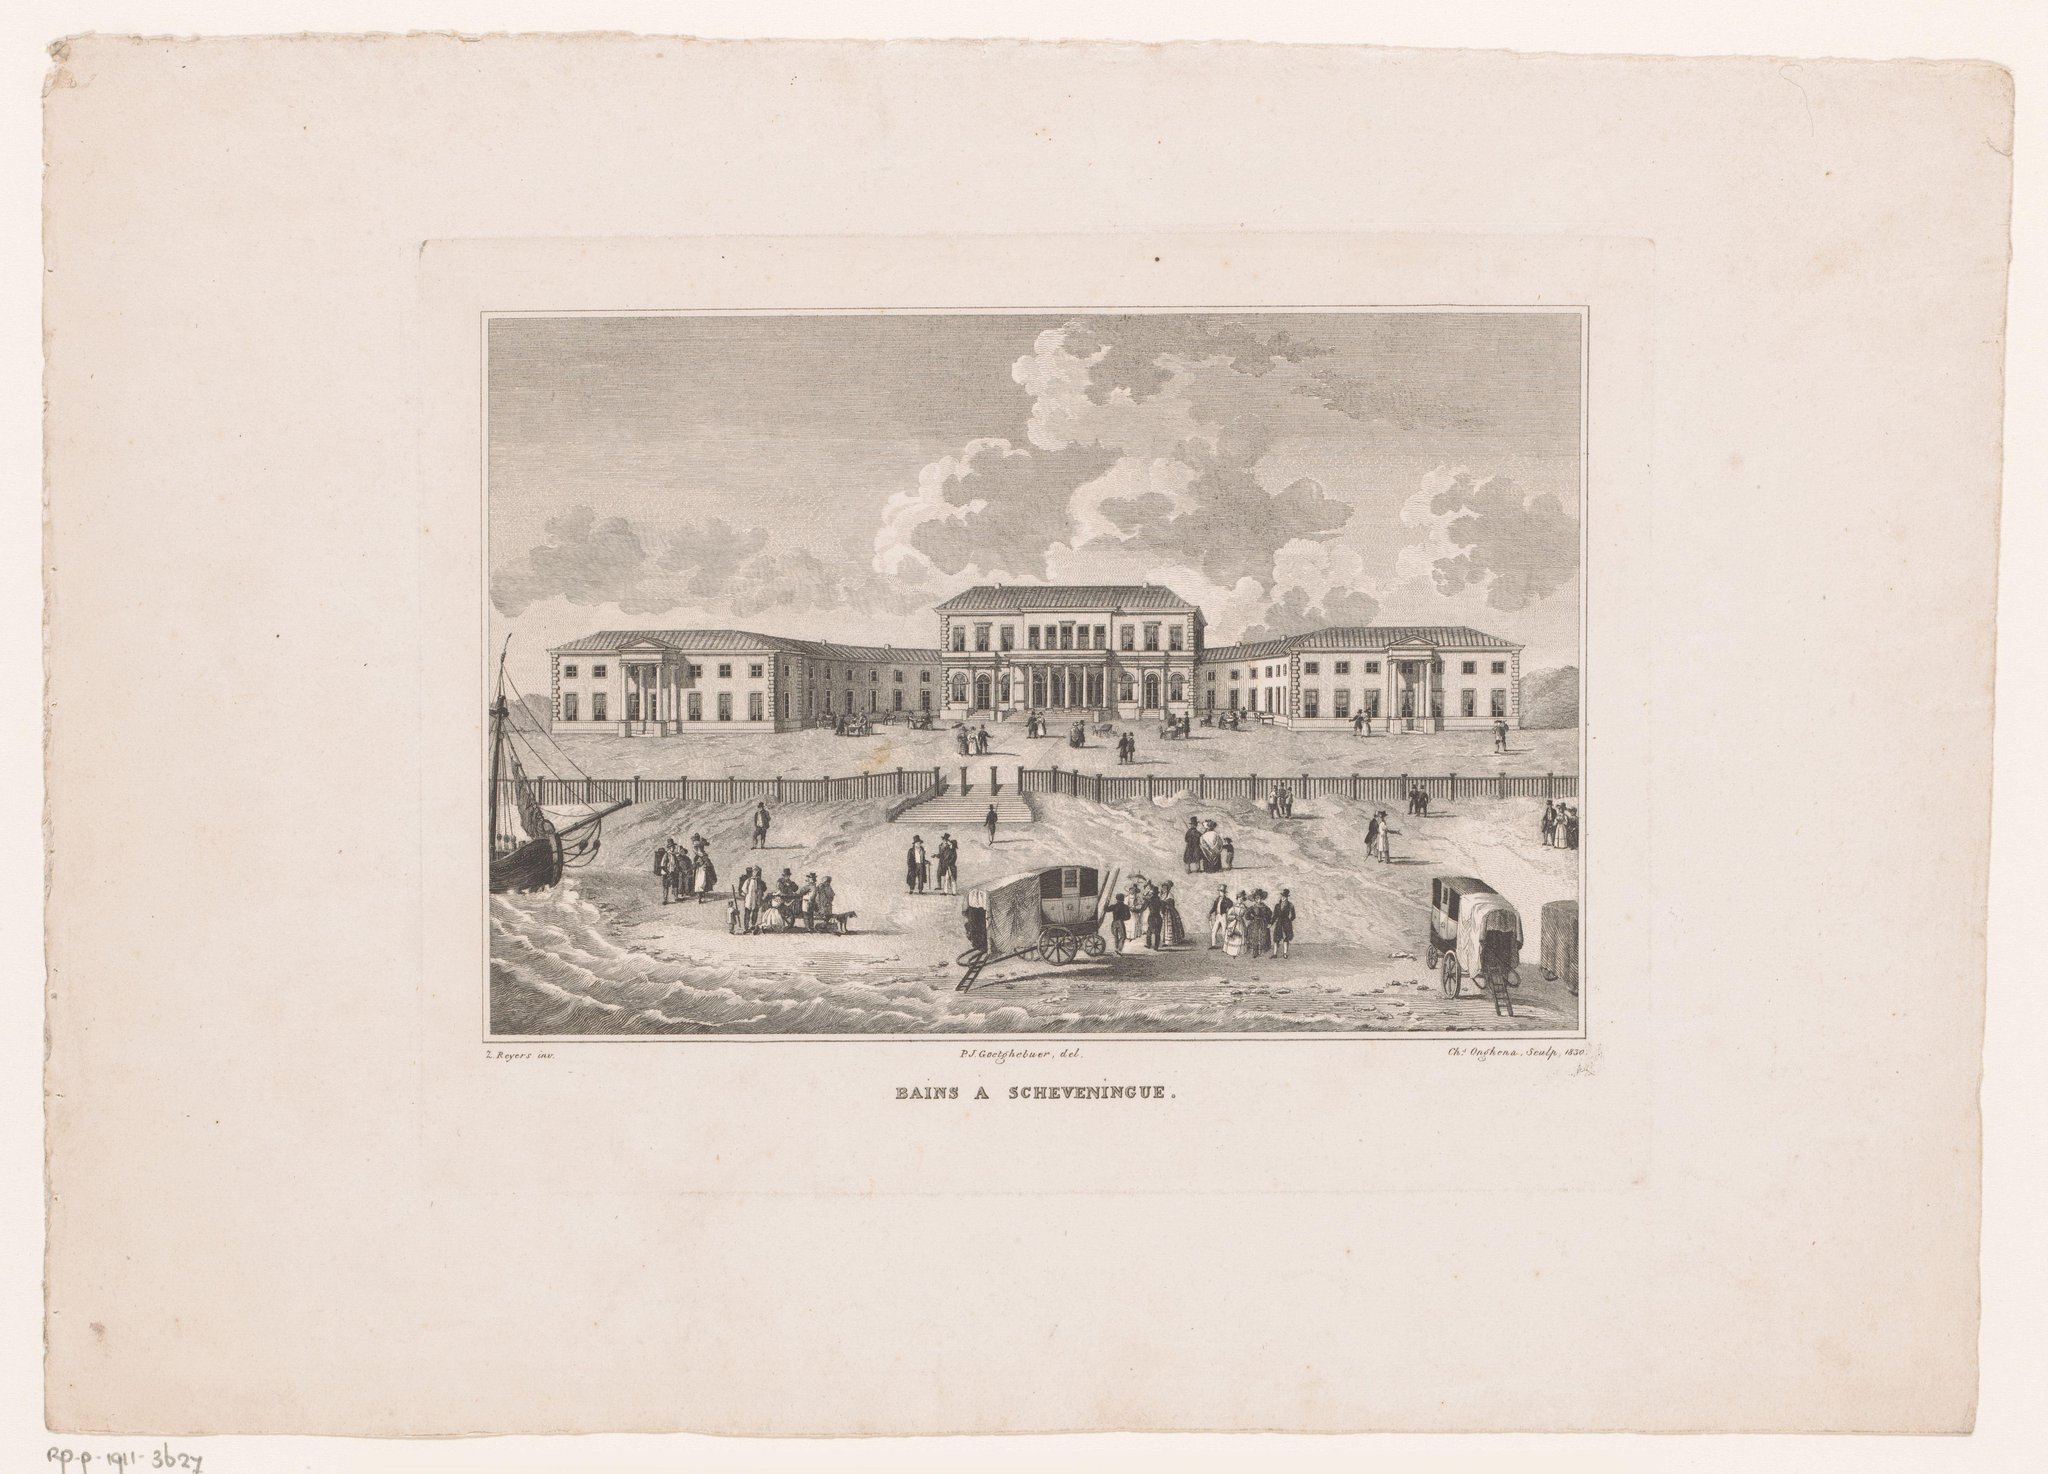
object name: print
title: Gezicht op het Stedelijk Badhuis aan het strand bij Scheveningen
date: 1830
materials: paper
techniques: etching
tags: public baths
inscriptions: collector's mark: Lugt 2228